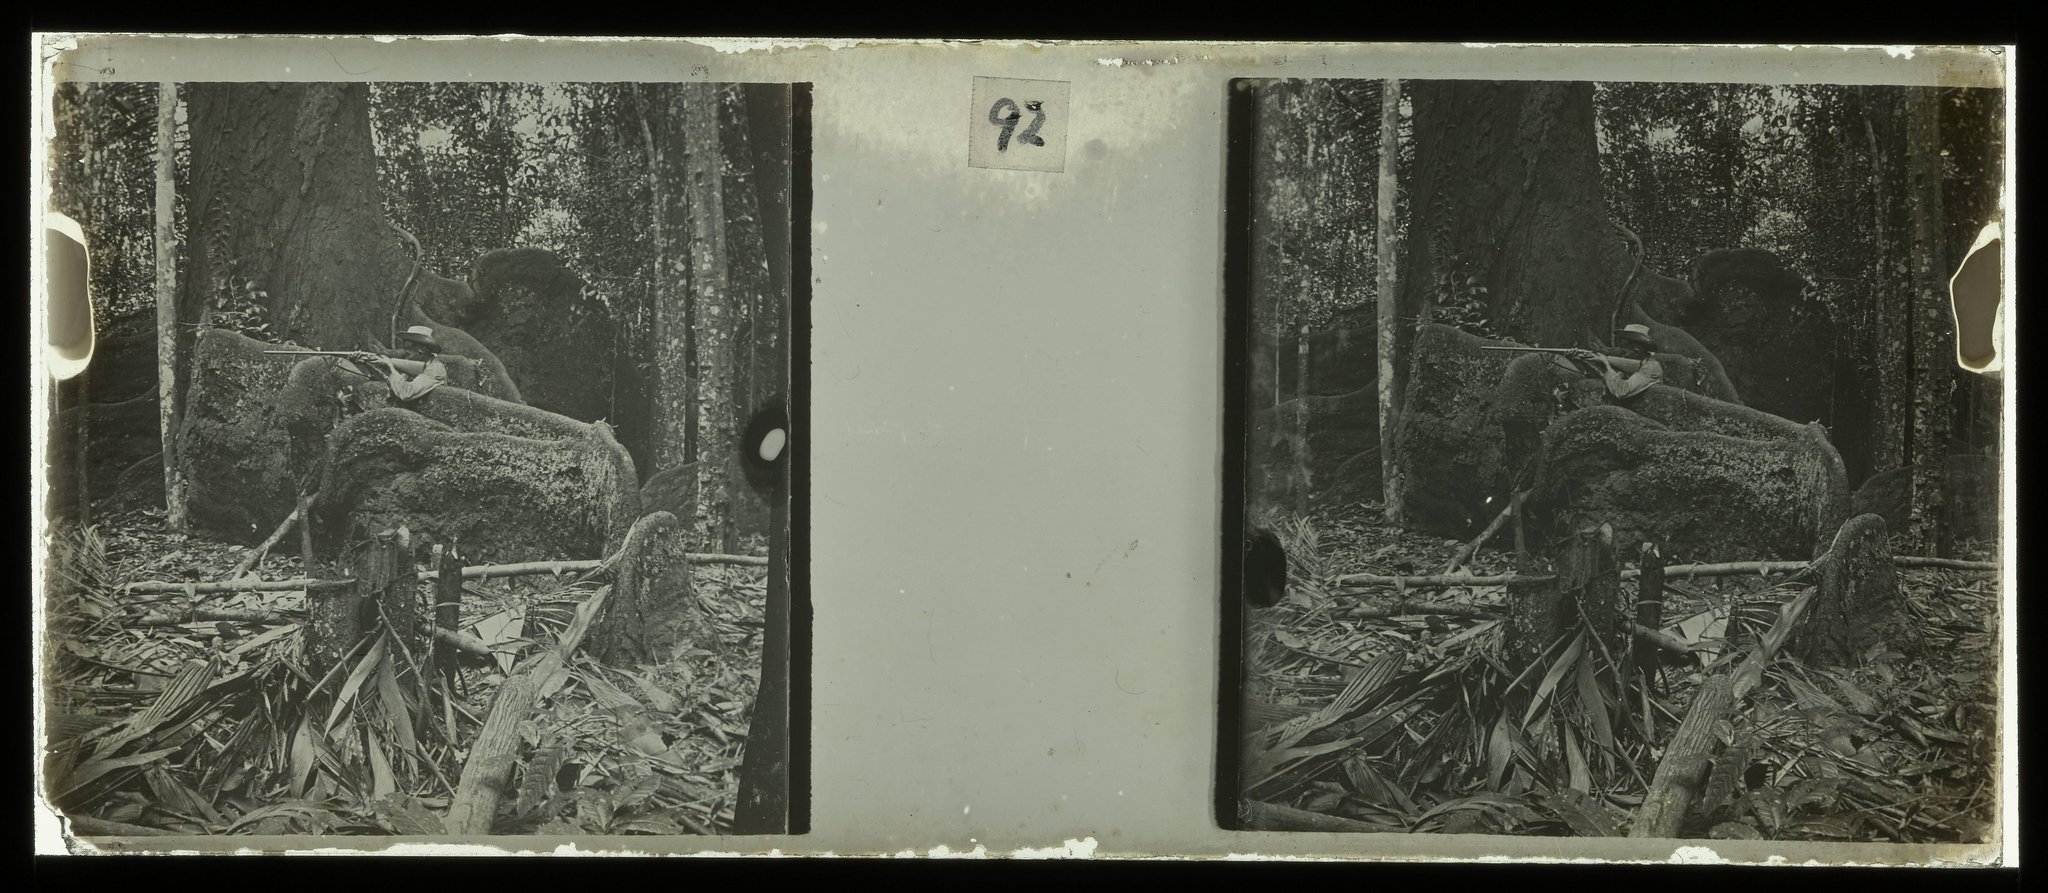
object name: stereograph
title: Plantage Accaribo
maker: theodoor brouwers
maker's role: amateurfotograaf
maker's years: 1874-1932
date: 1913-1930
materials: glass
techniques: photography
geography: suriname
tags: amsterdam, theodoor brouwers, plantation, suriname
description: In de periode 1911-1932 woonde op plantage Accaribo in Suriname de familie Brouwers van wie de foto's afkomstig zijn. Rond 1910 vond Theodoor Brouwers werk op plantage Accaribo. In 1929 werd hij eigenaar van de plantage. Op Accaribo werden in zijn tijd bananen geproduceerd en wat koffie.